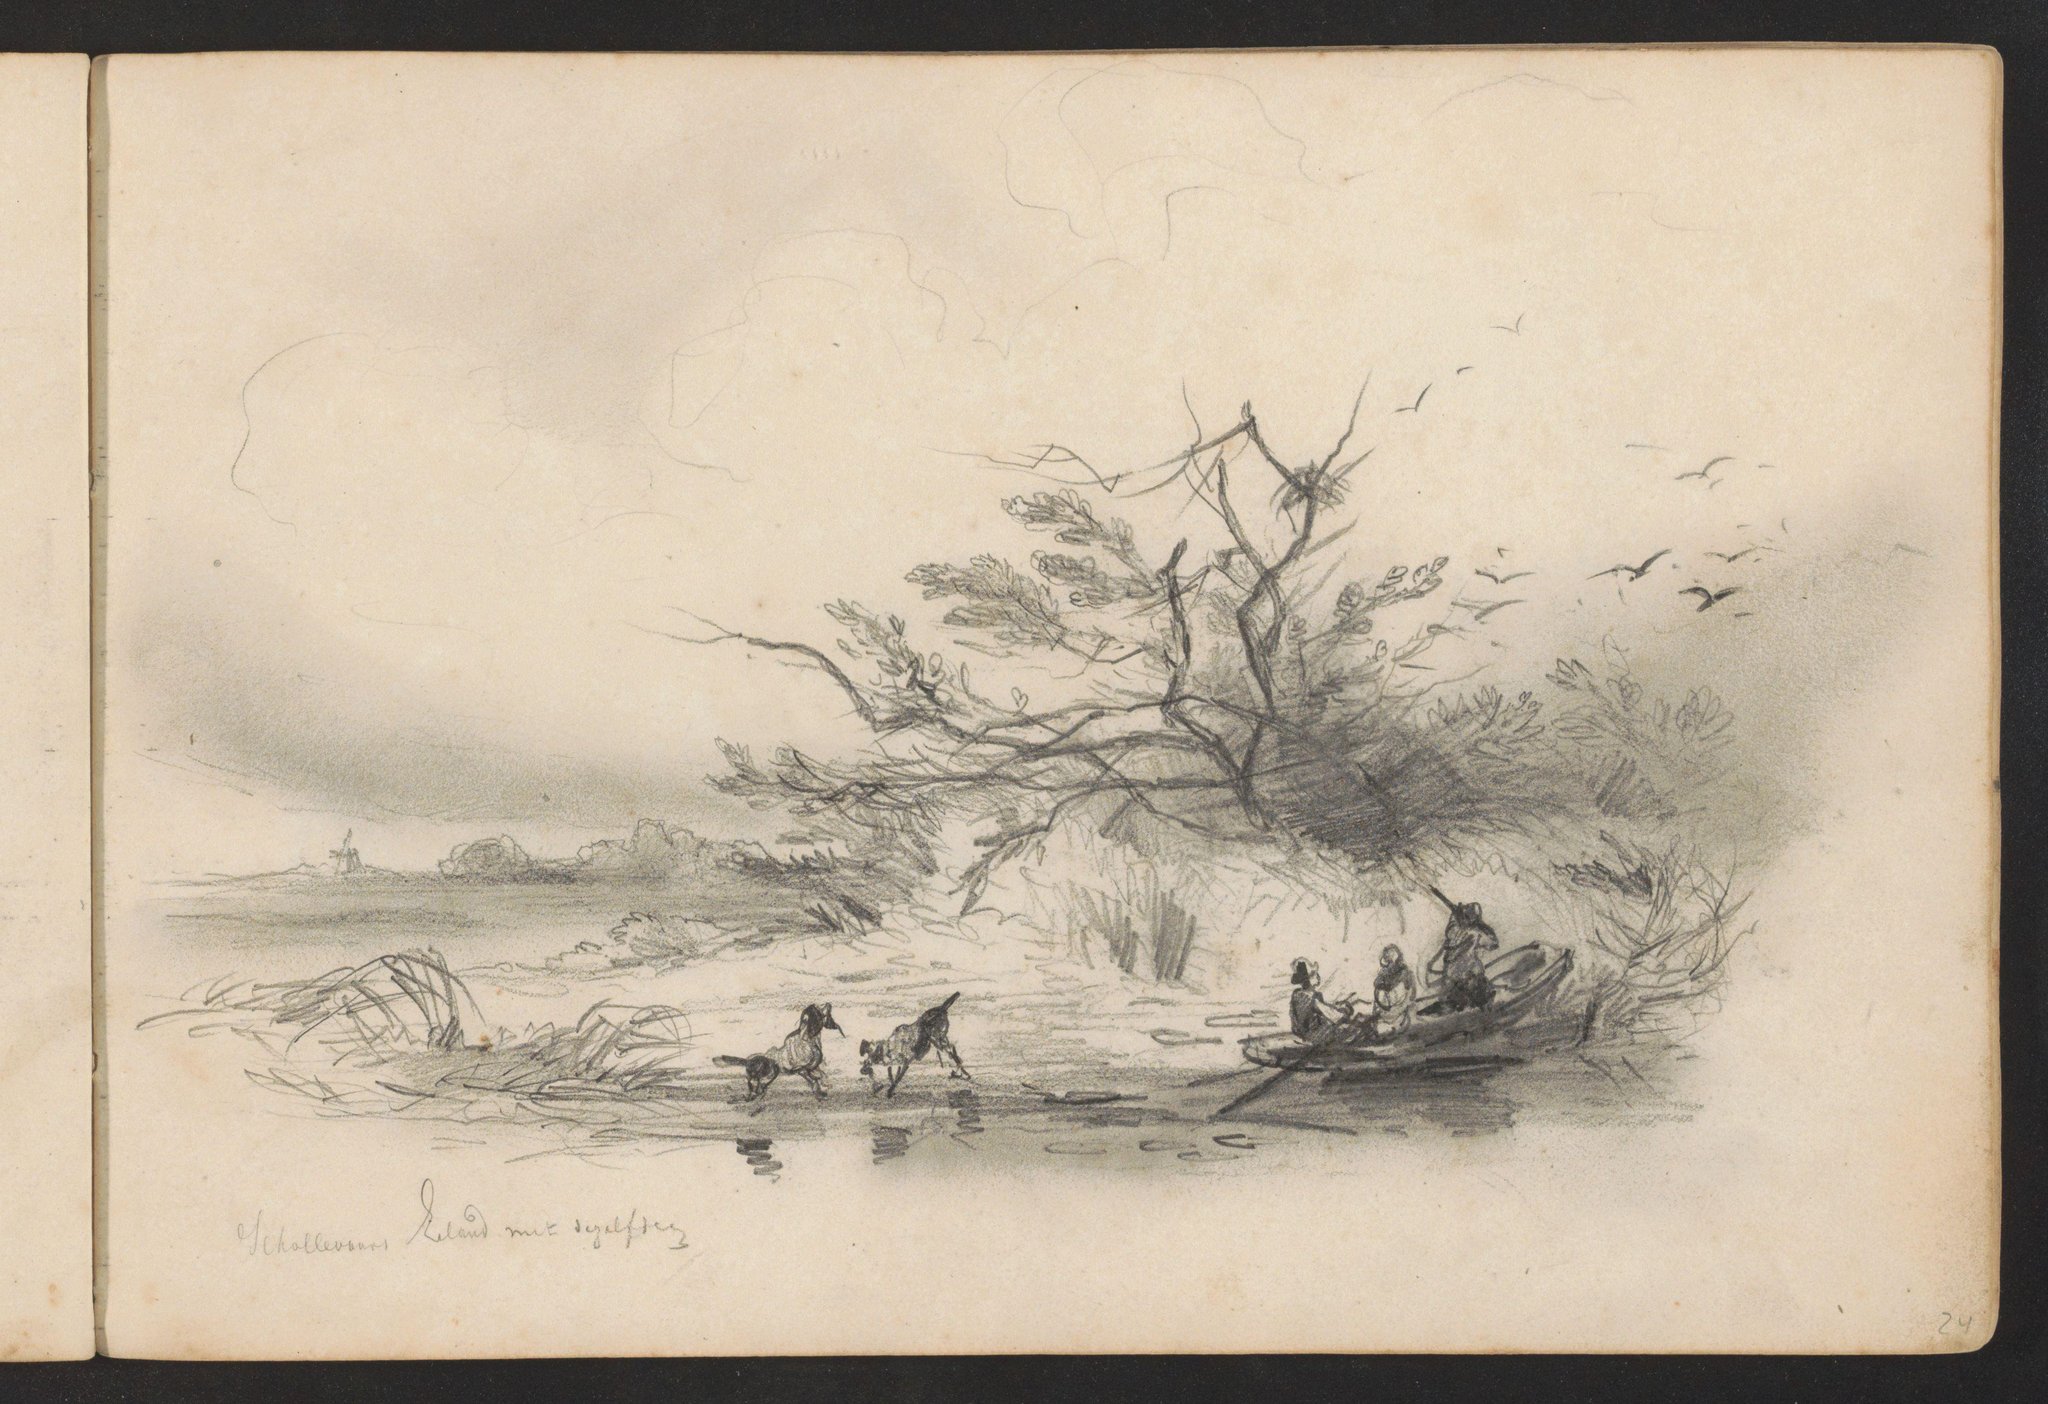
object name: sketchbook leaf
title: Schollevaarseiland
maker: johannes tavenraat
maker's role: draughtsman, painter, print maker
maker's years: 1809-1881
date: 1843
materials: paper, pencil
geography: south holland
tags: island, birds, rowing-boat, canoe, etc.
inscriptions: annotation: ‘Schollevaars Eiland met dezelven’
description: Blad 24 recto in een schetsboek met 45 bladen.